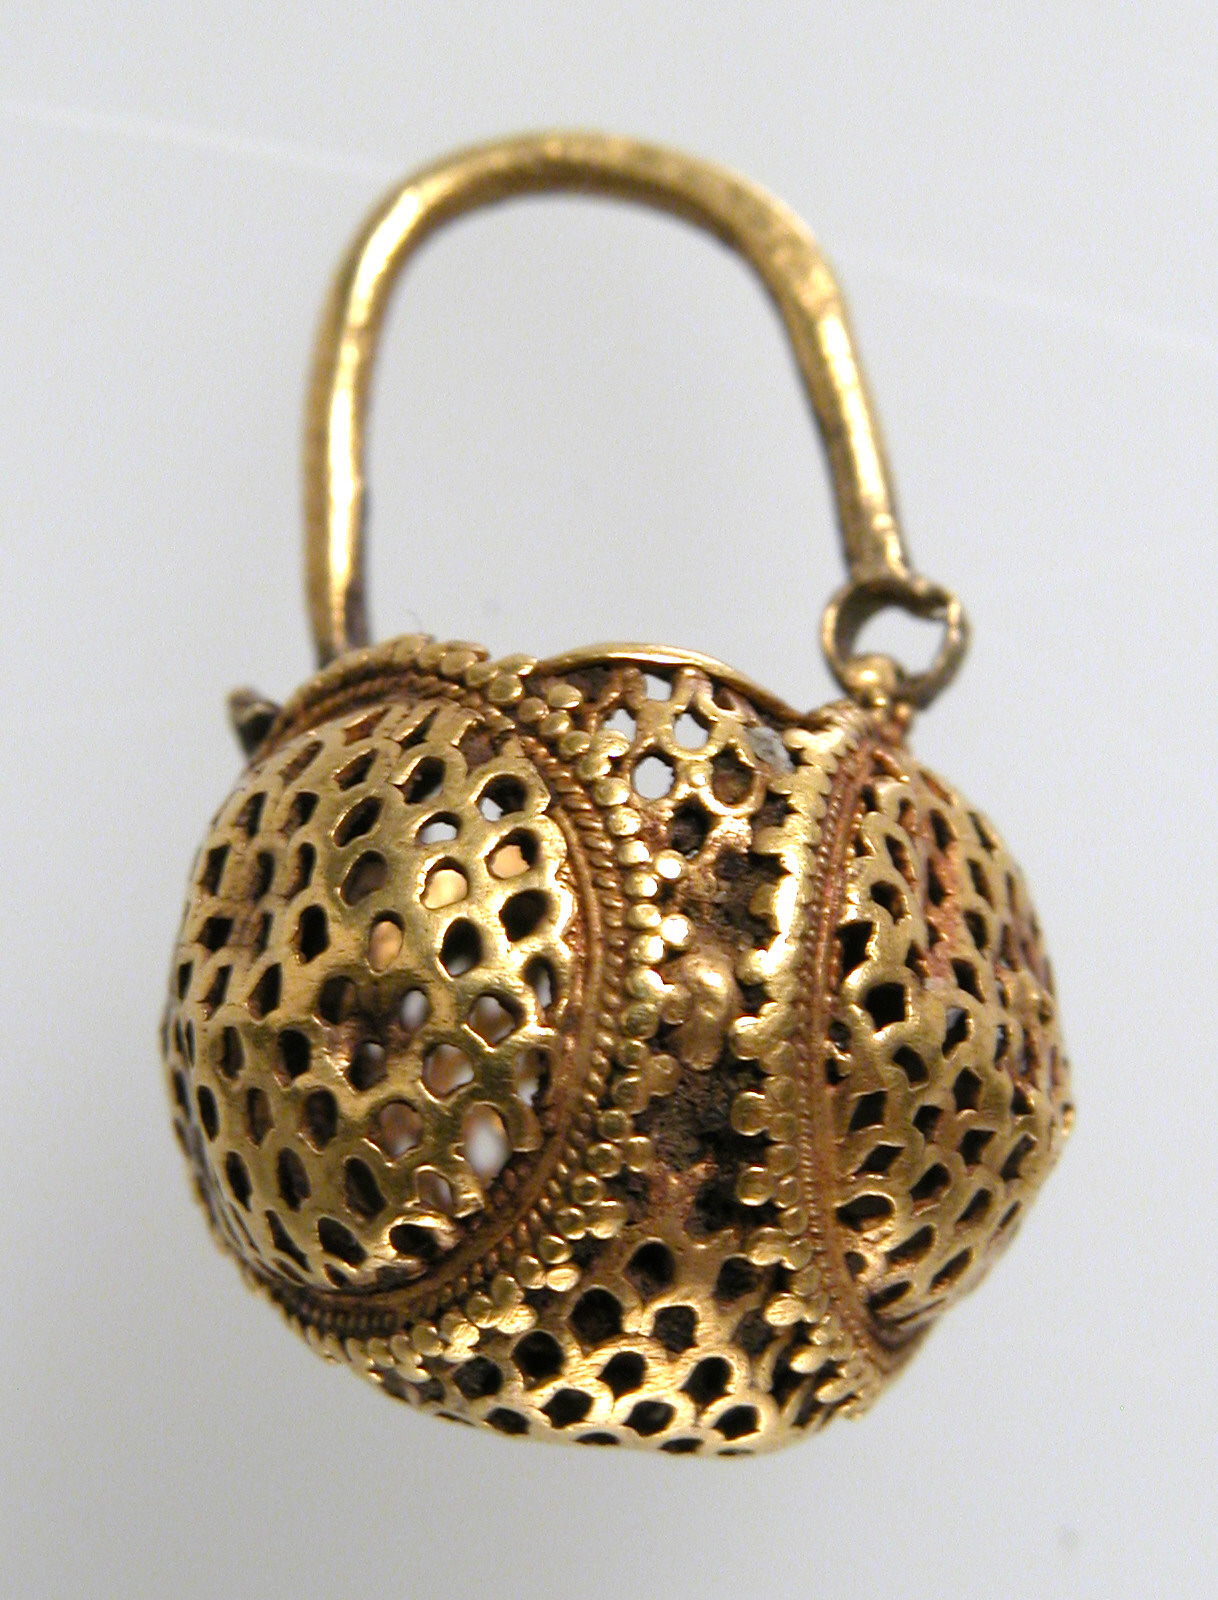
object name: earring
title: Gold "Basket" Earring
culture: byzantine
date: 501-600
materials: gold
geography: northern france